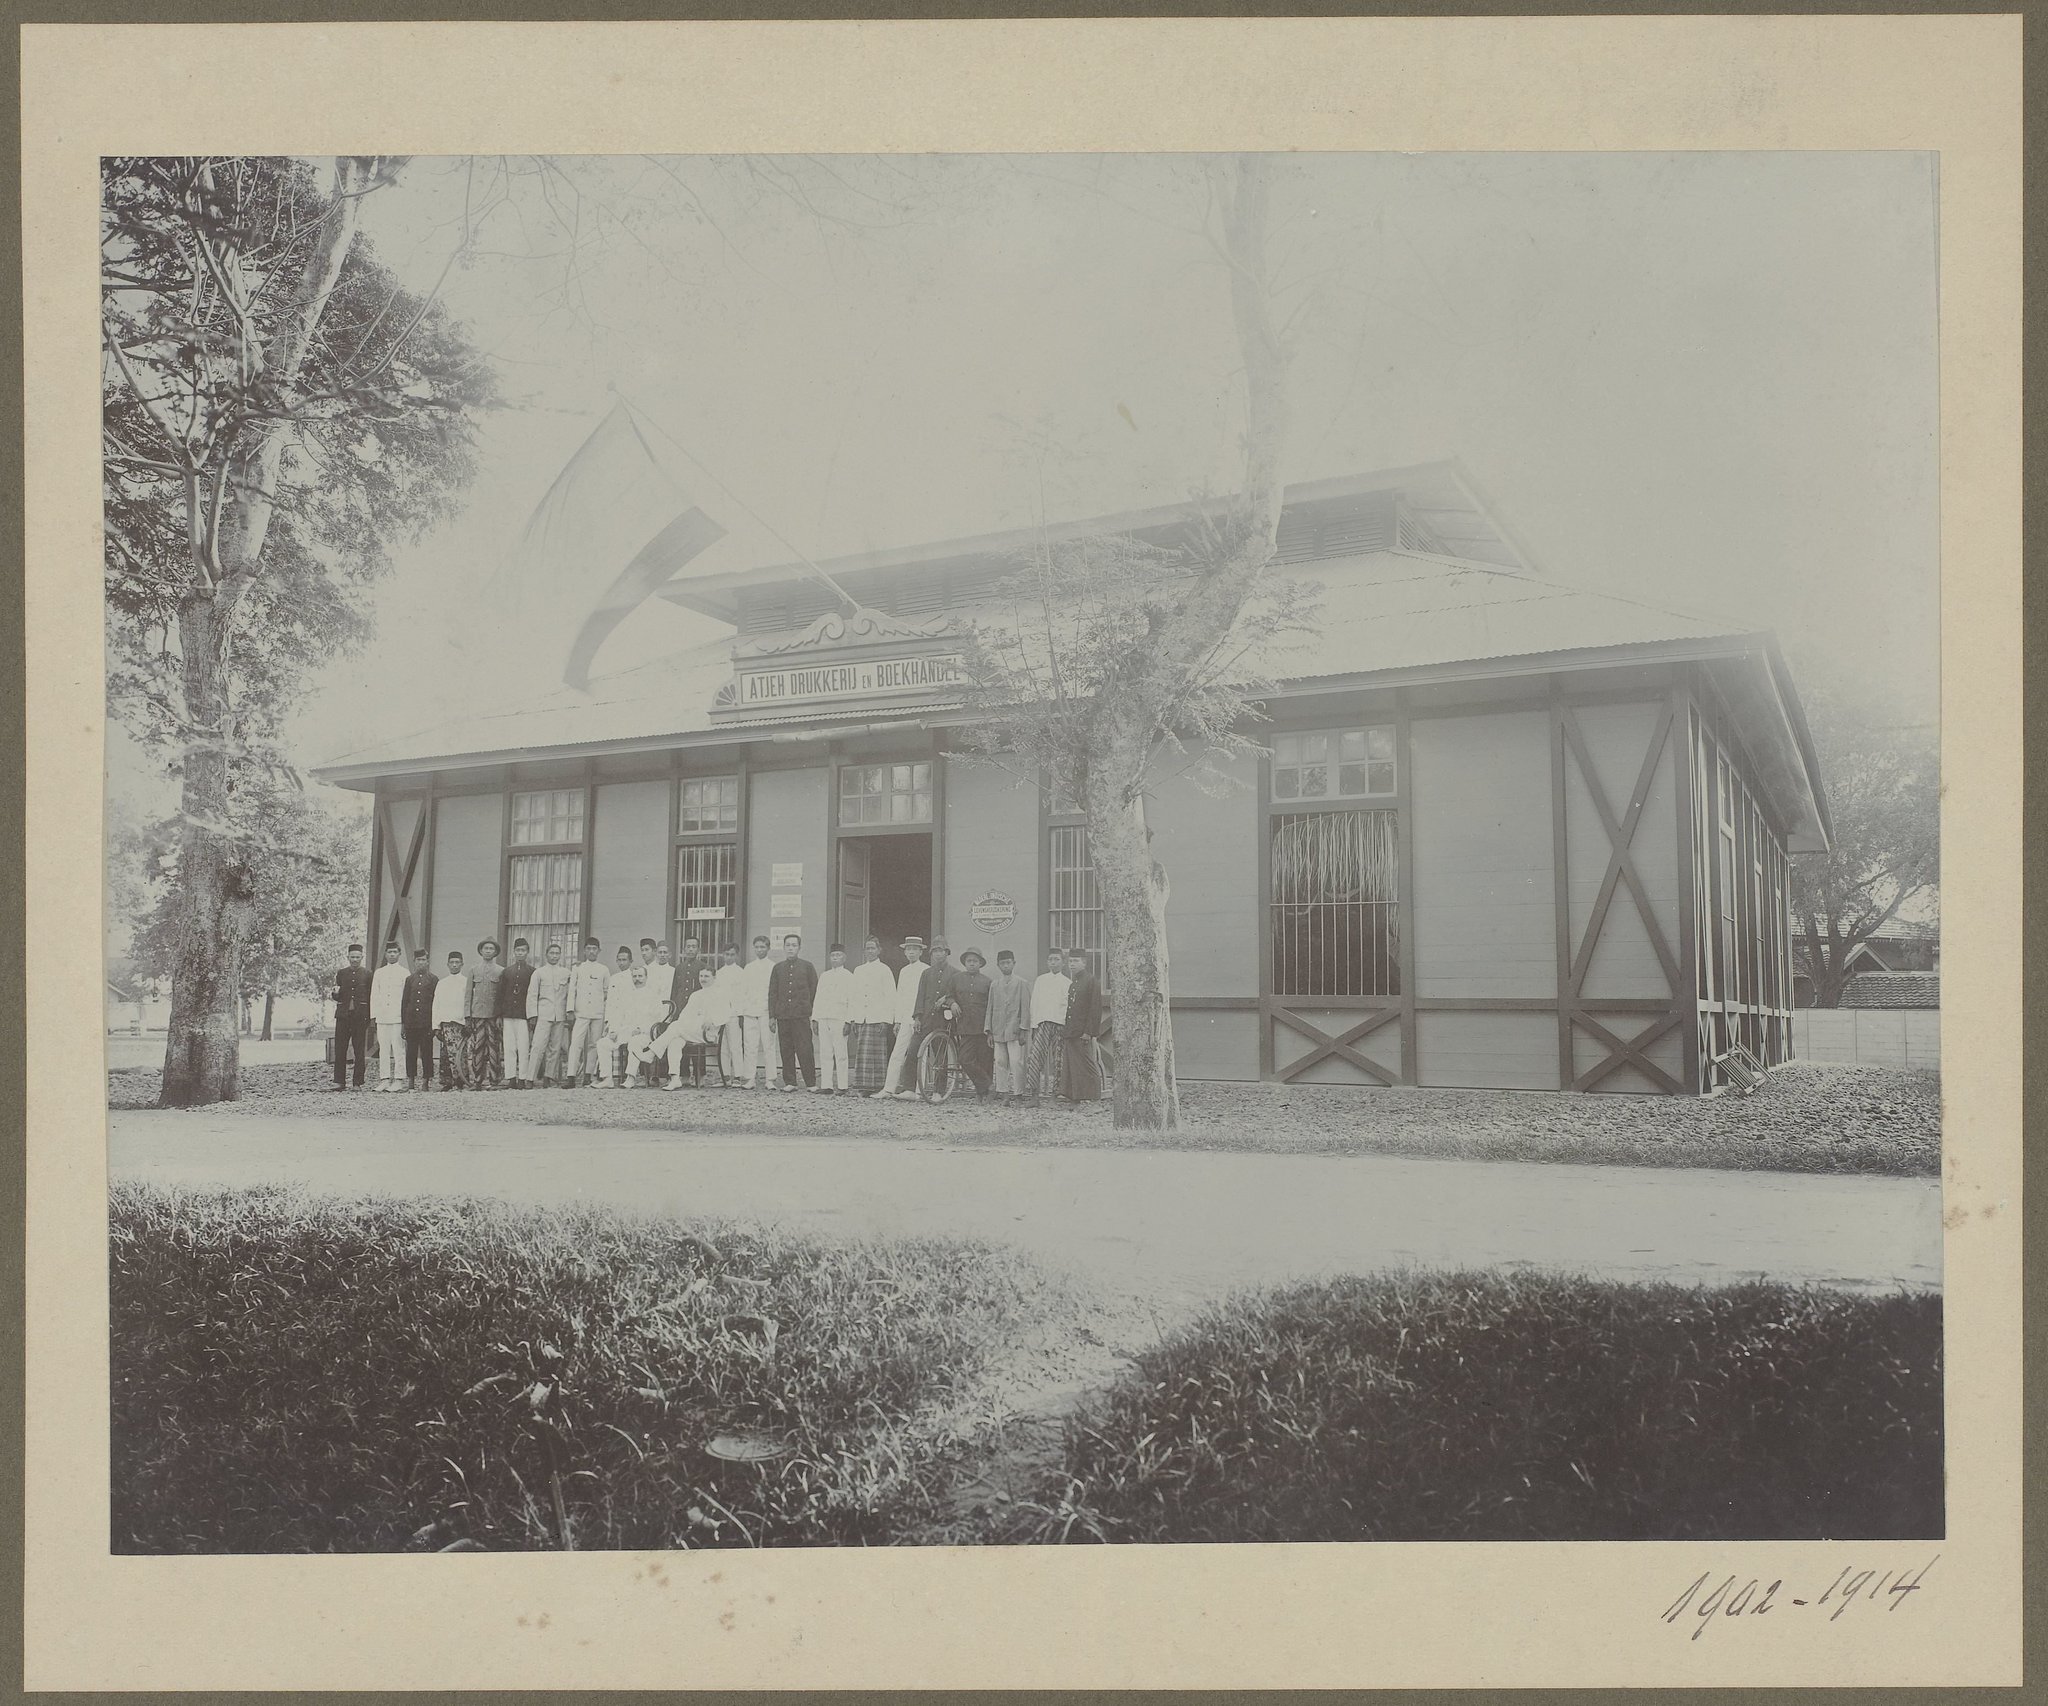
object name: photograph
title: Atjeh Drukkerij en Boekhandel te Koetaradja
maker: Anonymous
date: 1902-1914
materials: cardboard, photographic support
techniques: gelatin silver print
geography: banda atjeh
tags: dutch east indies, the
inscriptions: inscription: ‘1902-1914’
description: Groepsfoto van de werknemers van de Atjeh Drukkerij en Boekhandel te Koetaradja (Banda Atjeh) poserend voor de deur van het gebouw, ca. 1902-1914. Foto opgeplakt op karton. Onderdeel van een groep van negen foto's over de Atjeh-drukkerij.